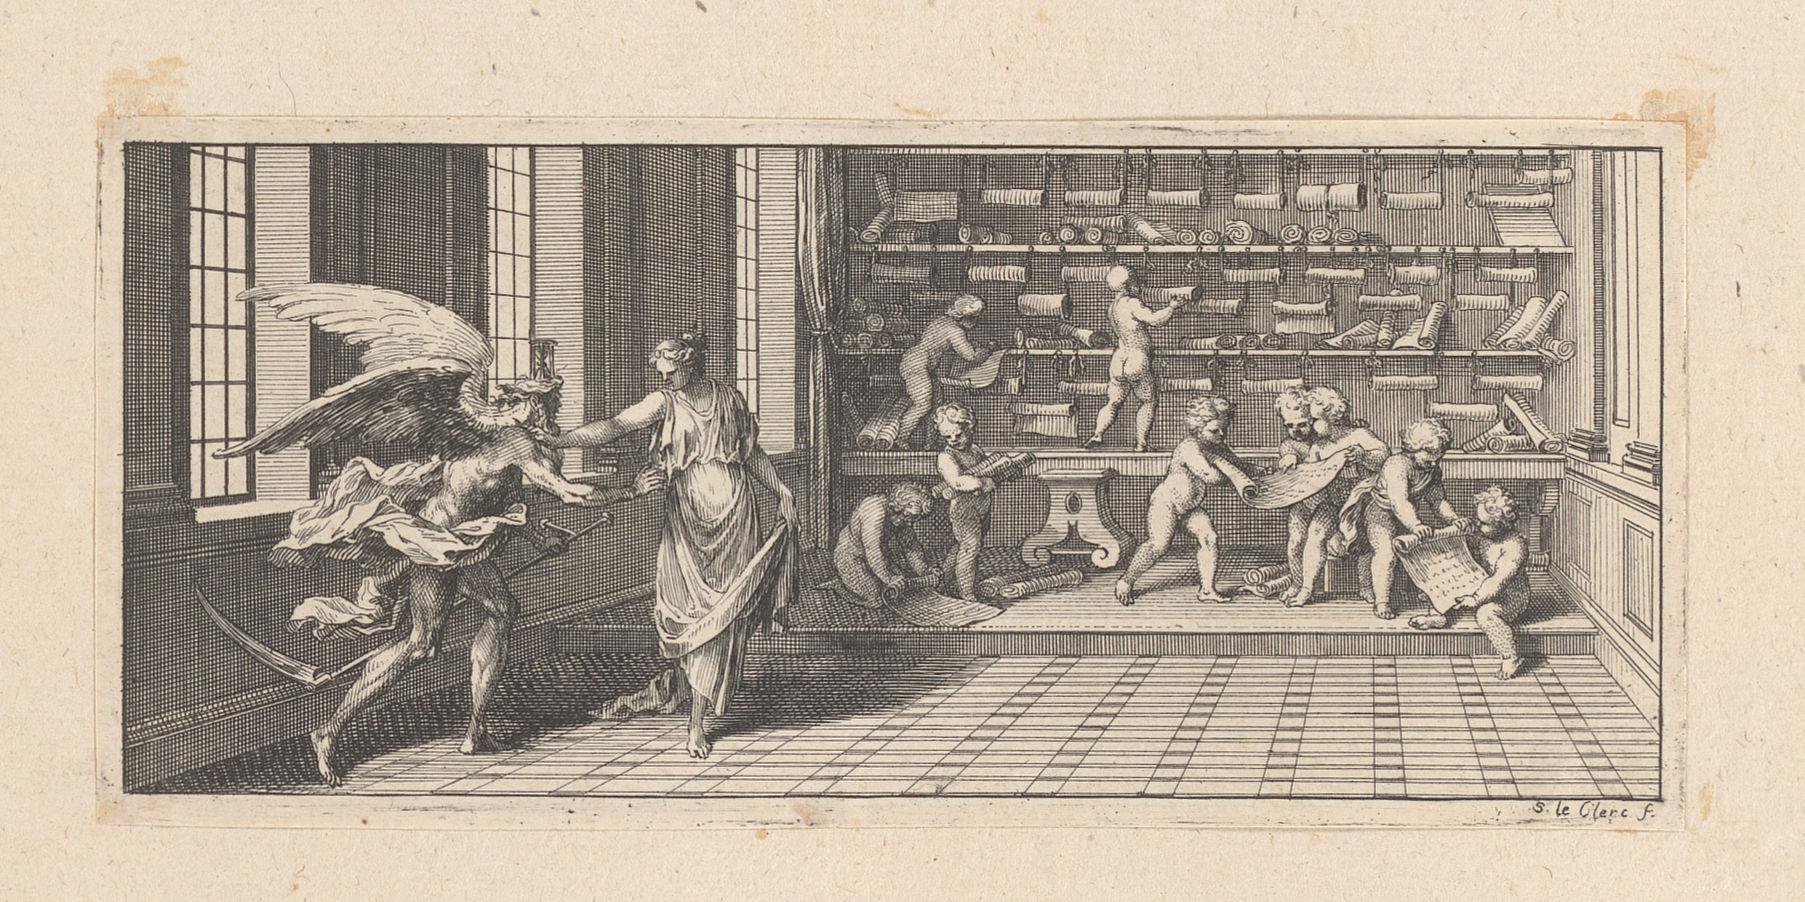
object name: album leaf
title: Vignet met een vrouw (mogelijk Victorie) die Vader Tijd uit een bibliotheek met putti verdrijft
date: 1687-1701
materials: paper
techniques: etching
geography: toulouse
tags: victory, vignette, public library, cupids: 'amores', 'amoretti', 'putti', father time, man with wings and scythe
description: Prent waarschijnlijk gebruikt voor: La Faille, Germain de. Annales de la ville de Toulouse depuis la réunion de la Comté de Toulouse à la couronne (...). Toulouse: Guillaume-Louis Colomyez en Jérôme Posuel, 1687-1701. Vignet gebruikt in 'Divers titres et actes pour servir de preuves (...)'.